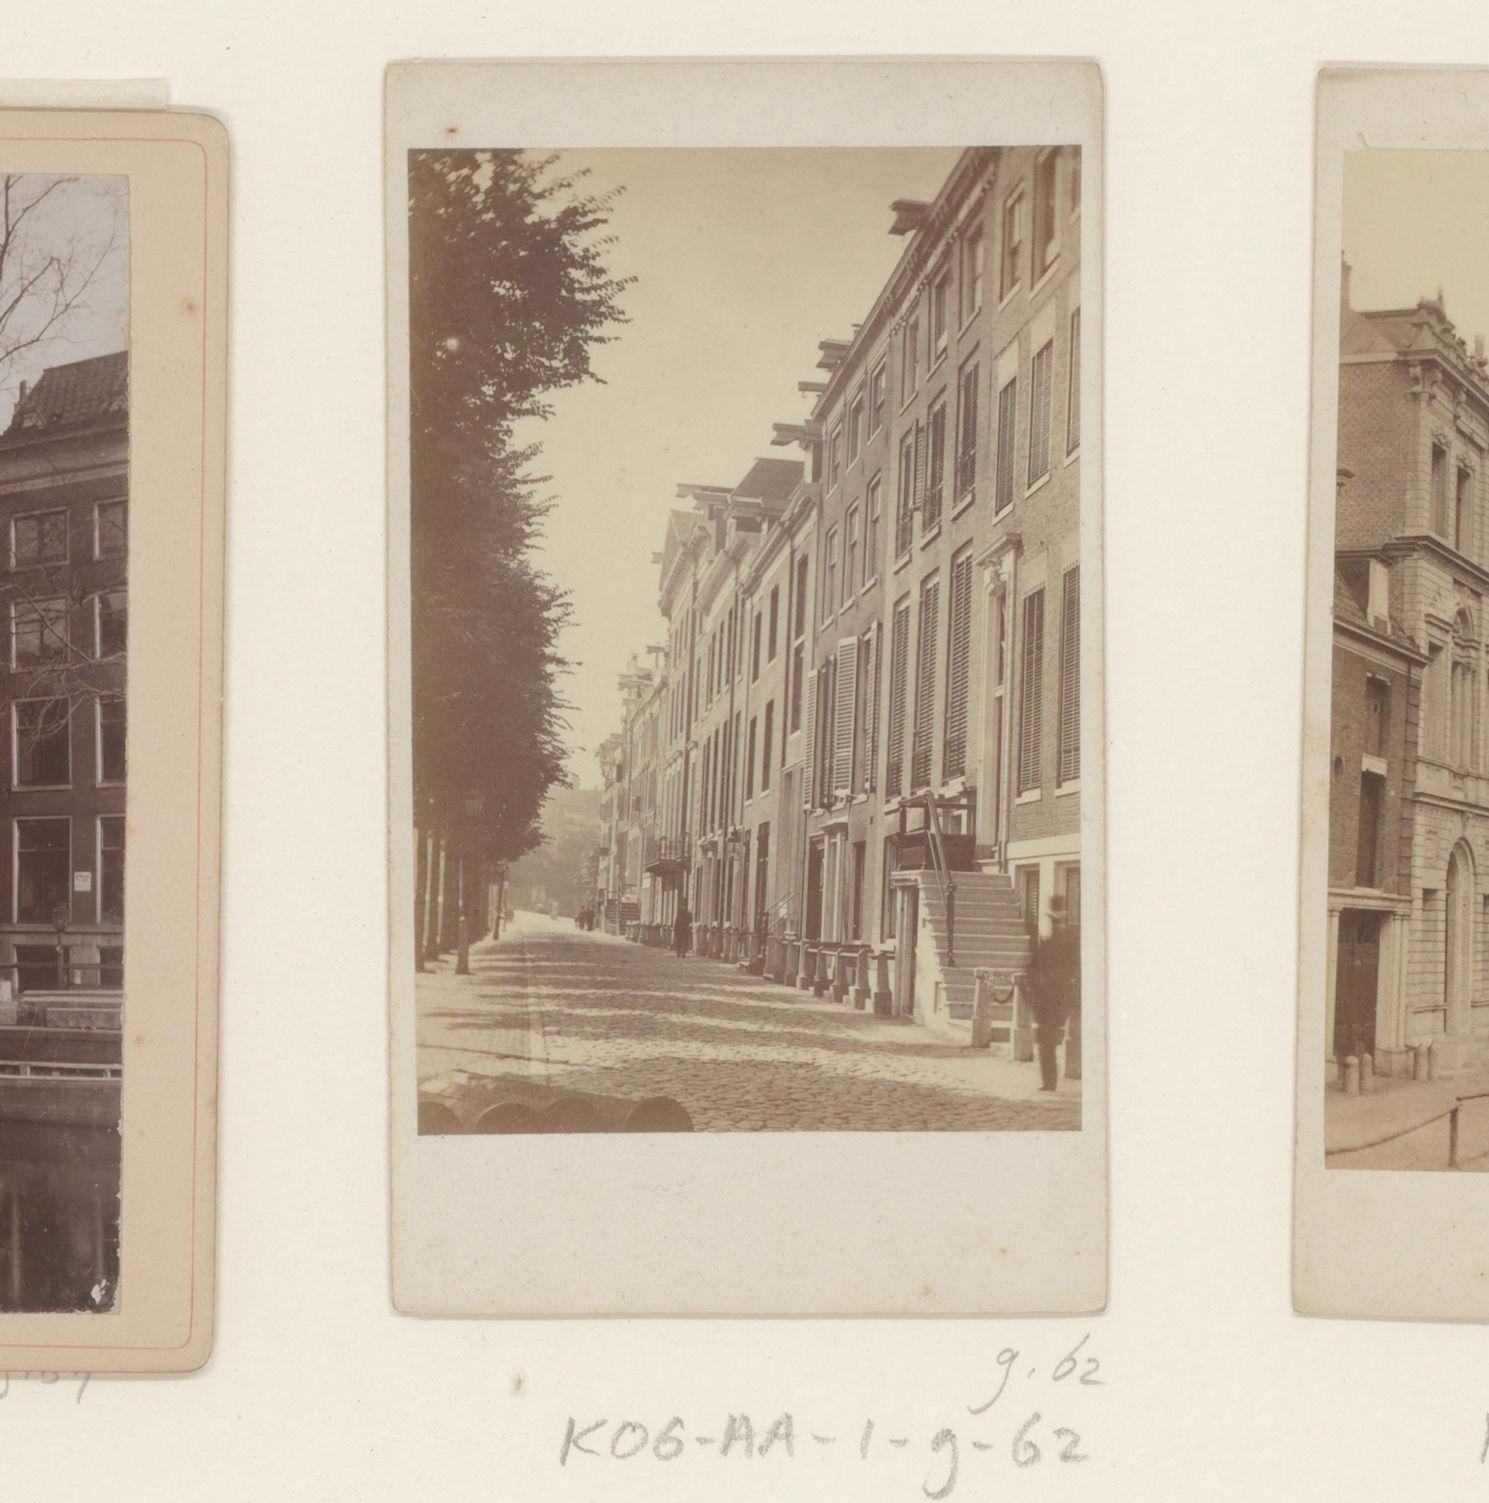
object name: carte de visite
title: Gezicht op de Keizersgracht bij de Spiegelstraat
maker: andries jager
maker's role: publisher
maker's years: 1825-1905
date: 1849-1885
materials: cardboard, paper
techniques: albumen print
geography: amsterdam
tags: city-view in general; 'veduta', the usual house or row of houses, street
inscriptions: inscription: ‘Keizergracht b/d Spie / gelstraat’, stamp: ‘A. Jager / Water, 110 / Amsterdam’, collector's mark: ‘9.62’ Lugt 1641b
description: Onderwerpsrubriek binnen de Atlas Amsterdam: Kadijksplein, Karthuizerkerkhof, Kattegat, Kattenburg, Kapelsteeg O.Z., Enge Kerksteeg, Kerkstraat, Kinkerstraat, Kolk O.Z., Koningsplein, Kromboomsloot [Krom Boomssloot], Kostverlorenkade, Kwakersdwarspad, Kalverstraat, Keizersgracht (v.d. Brouwersgracht – Amstel), Klerensloot (Gedempte), Klimopstraat, Kloveniersburgwal, Kraansluis.